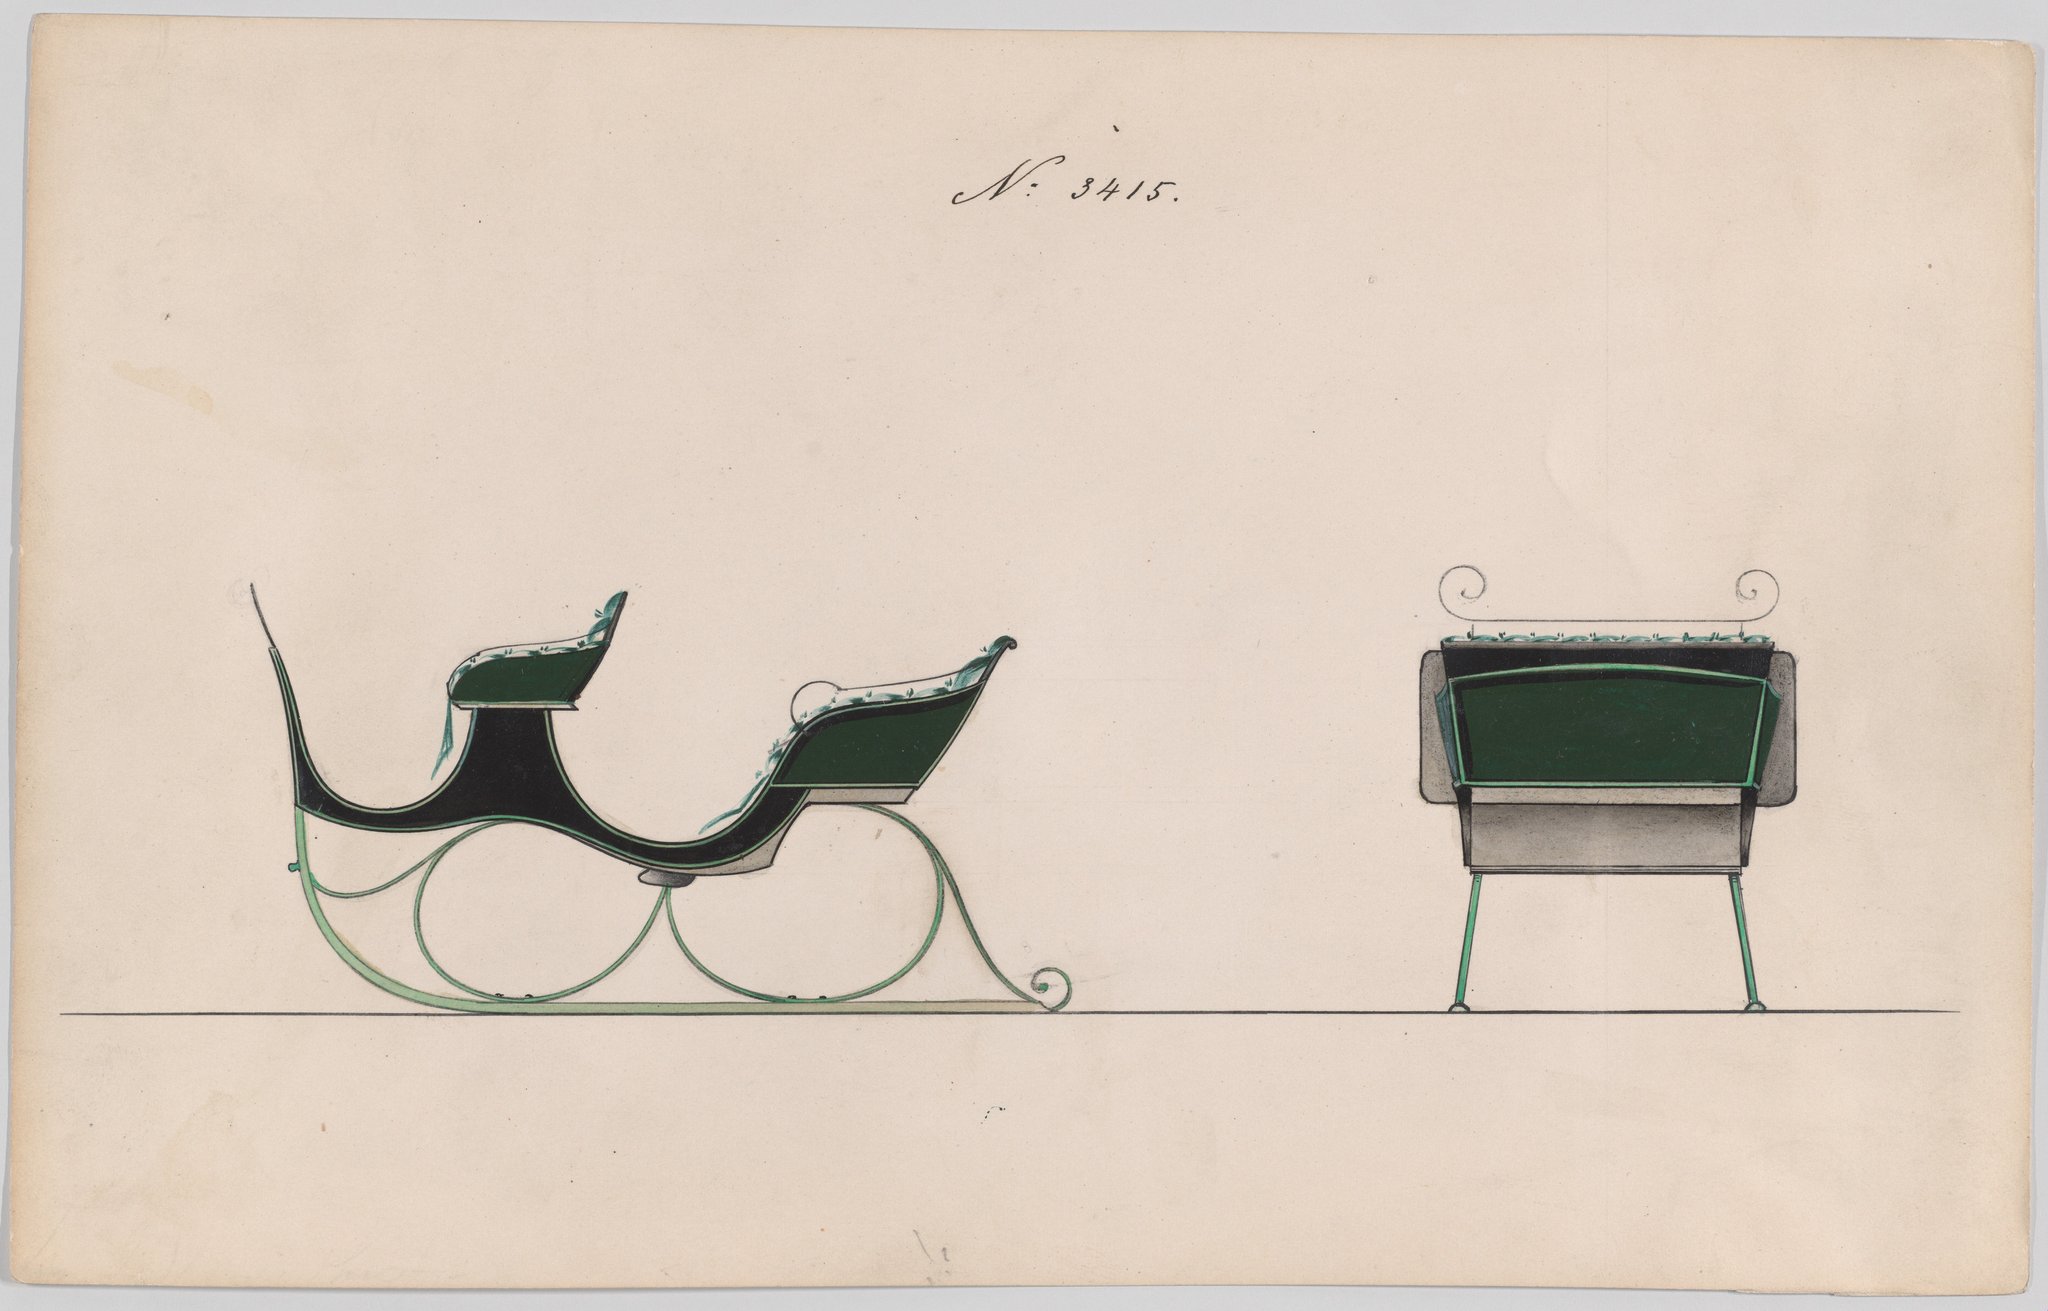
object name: drawing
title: Design for 4 Seat Sleigh, no. 3415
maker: brewster & co.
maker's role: manufacturer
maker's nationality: american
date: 1878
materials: gouache, gum arabic, ink, watercolor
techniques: pen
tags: sleighs